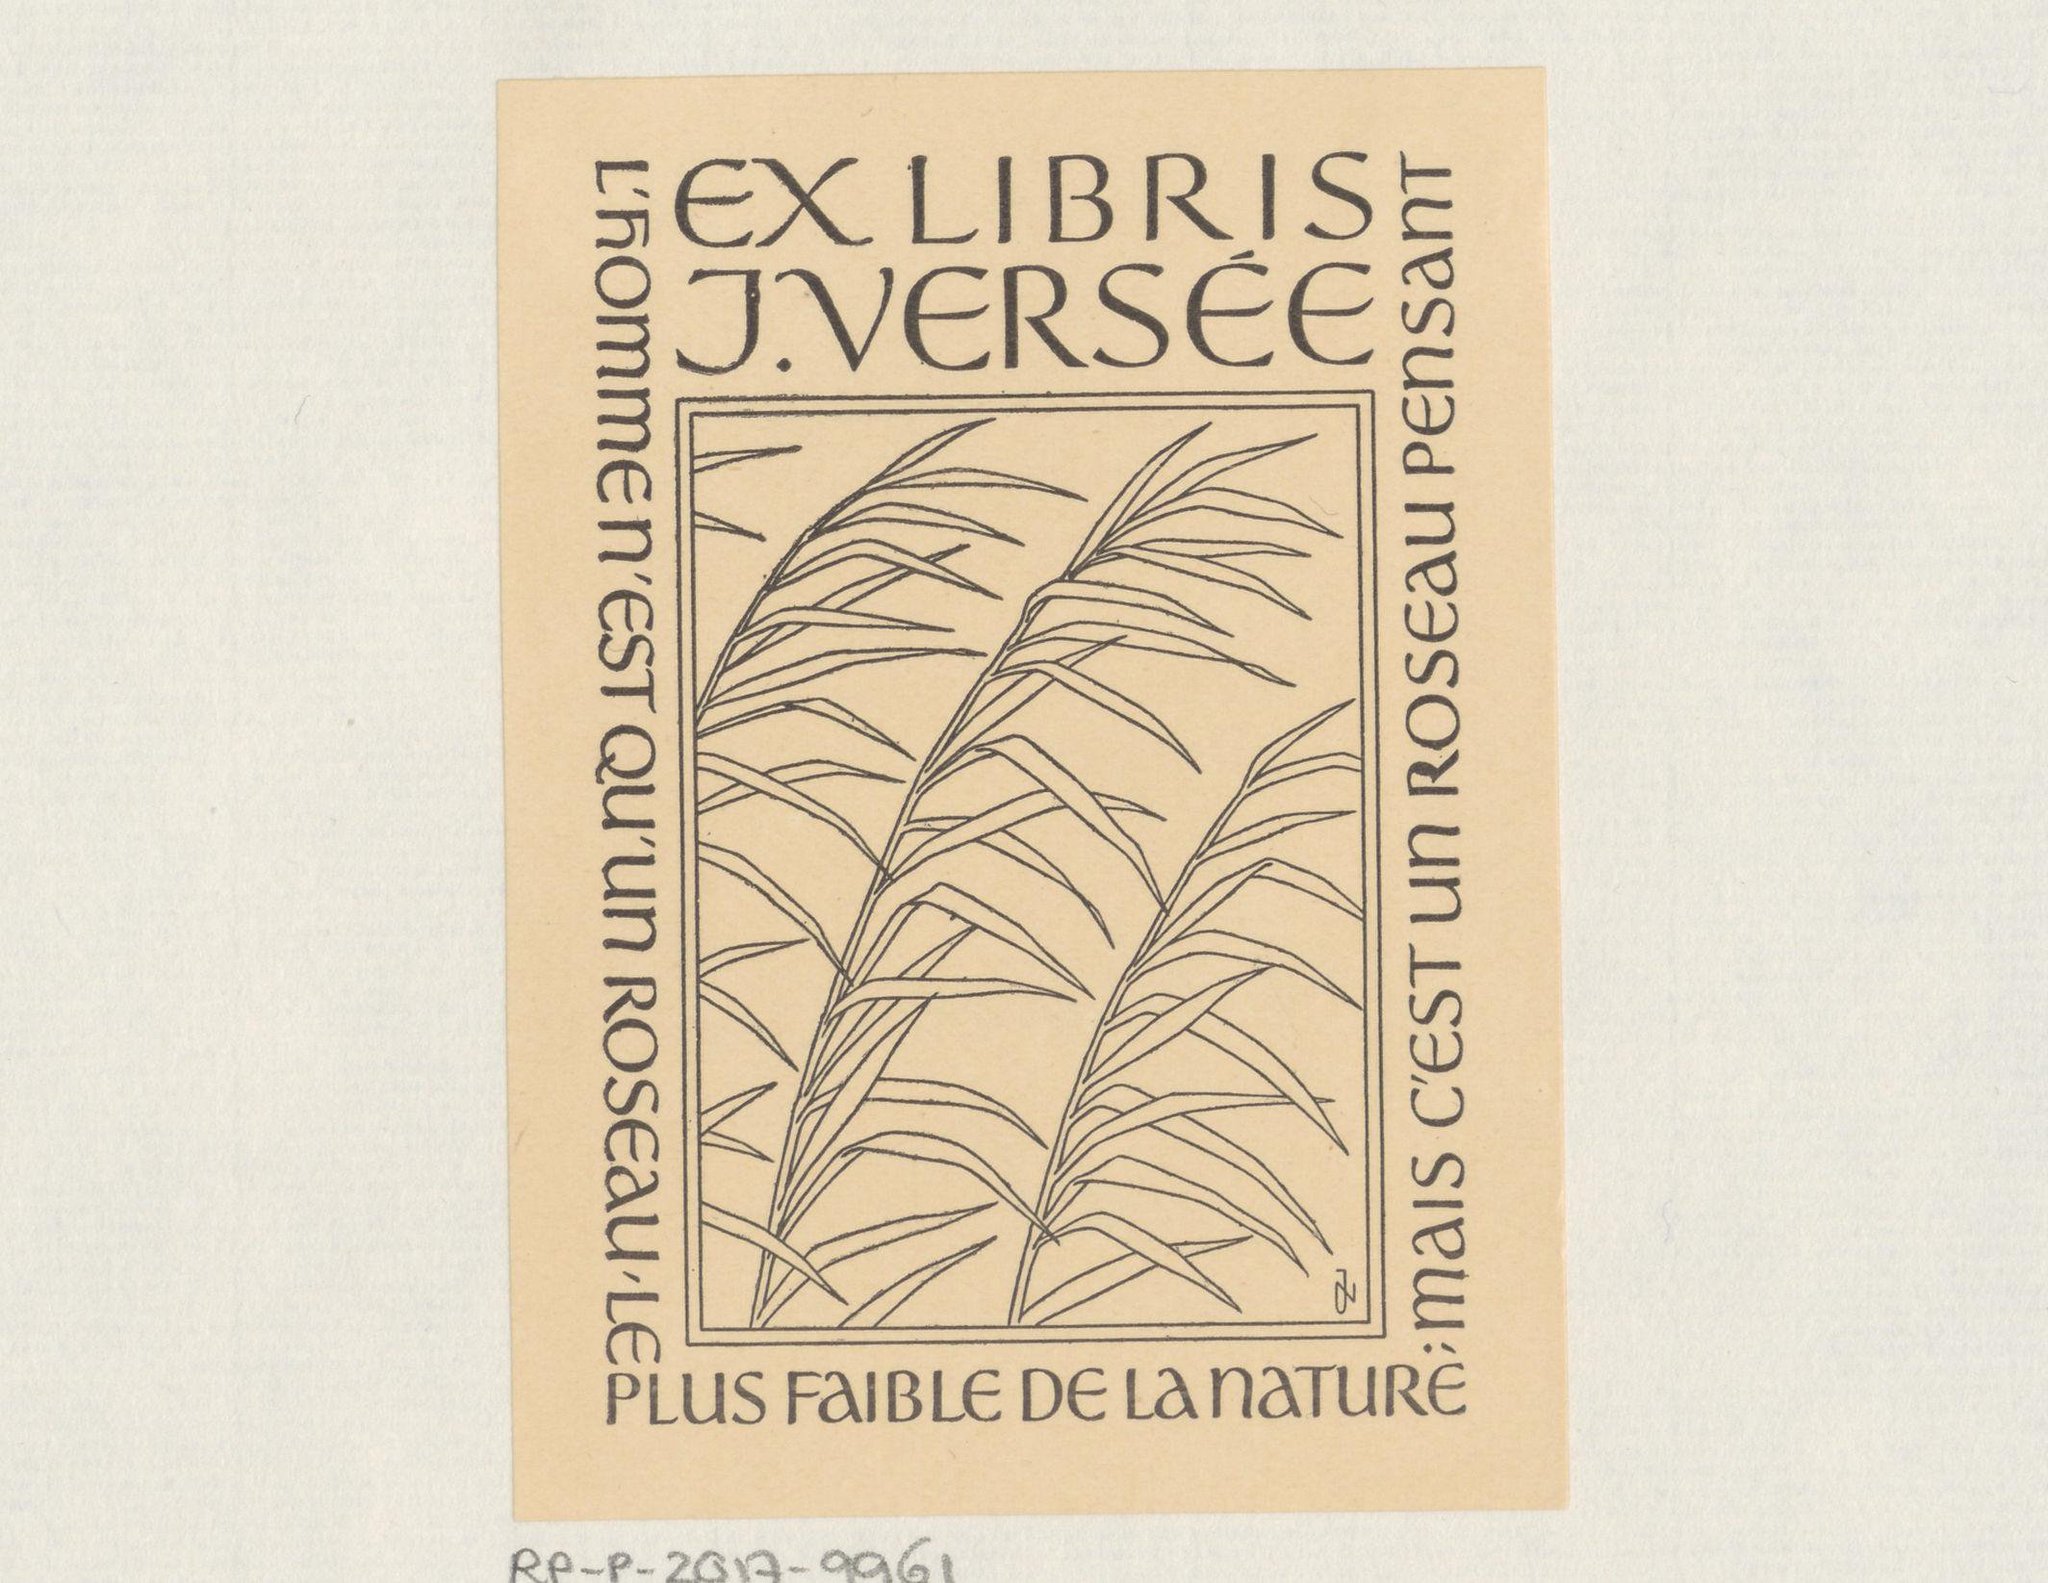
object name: bookplate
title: L'homme n'est qu'un roseau, le plus faible de la nature; mais c'est un roseau pensant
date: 1946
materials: paper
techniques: printing block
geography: netherlands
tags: plants and herbs: reed